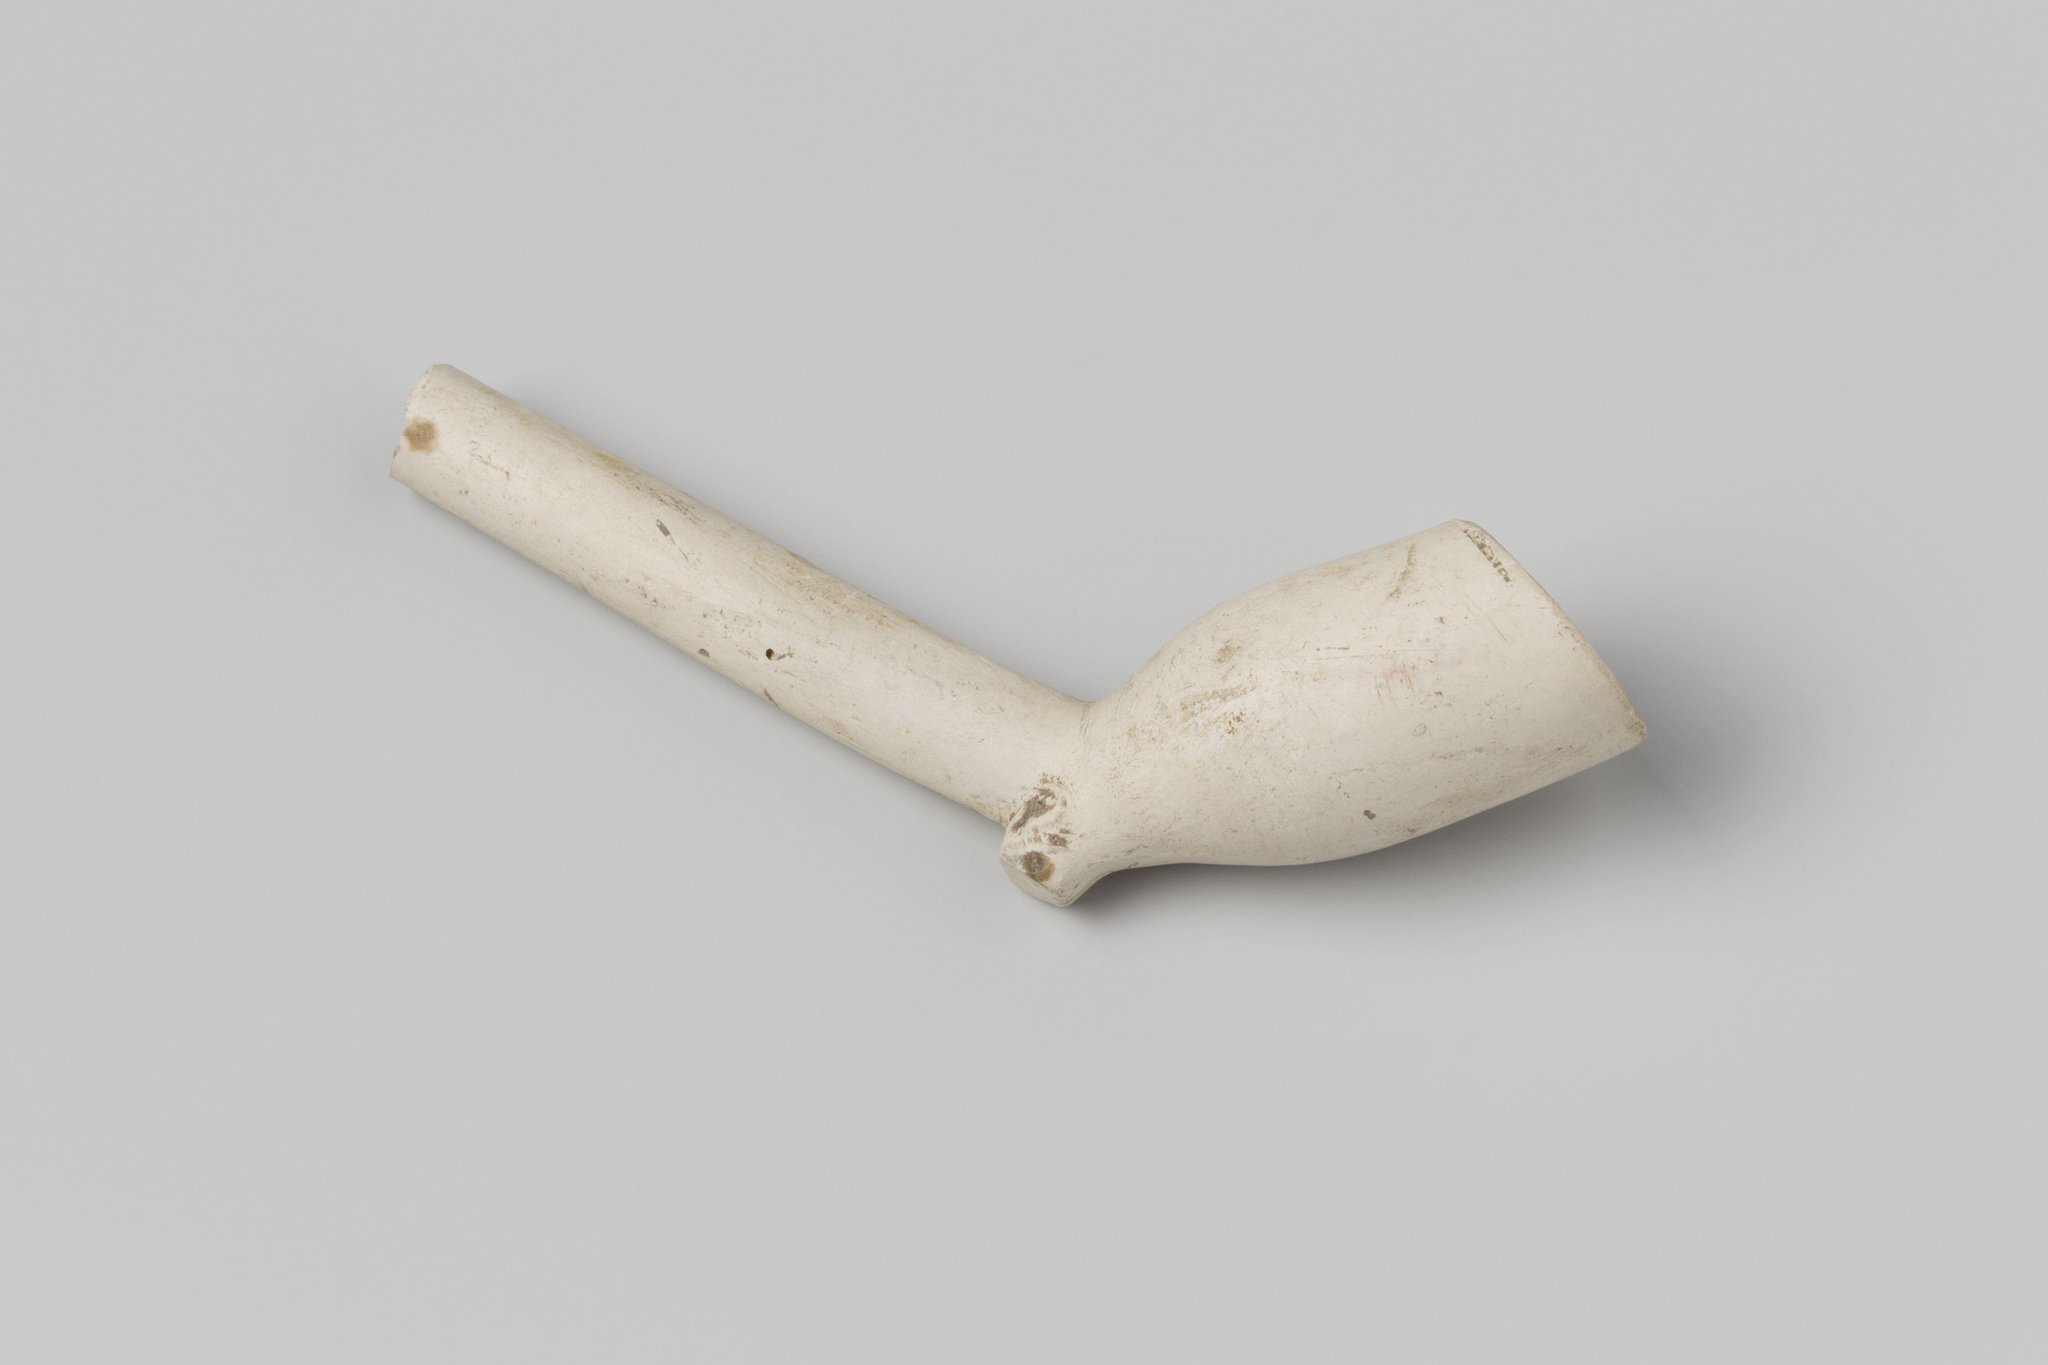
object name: pipe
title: Fragment van een tabakspijp.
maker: Anonymous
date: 1400-1950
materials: earthenware, clay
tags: loevestein castle